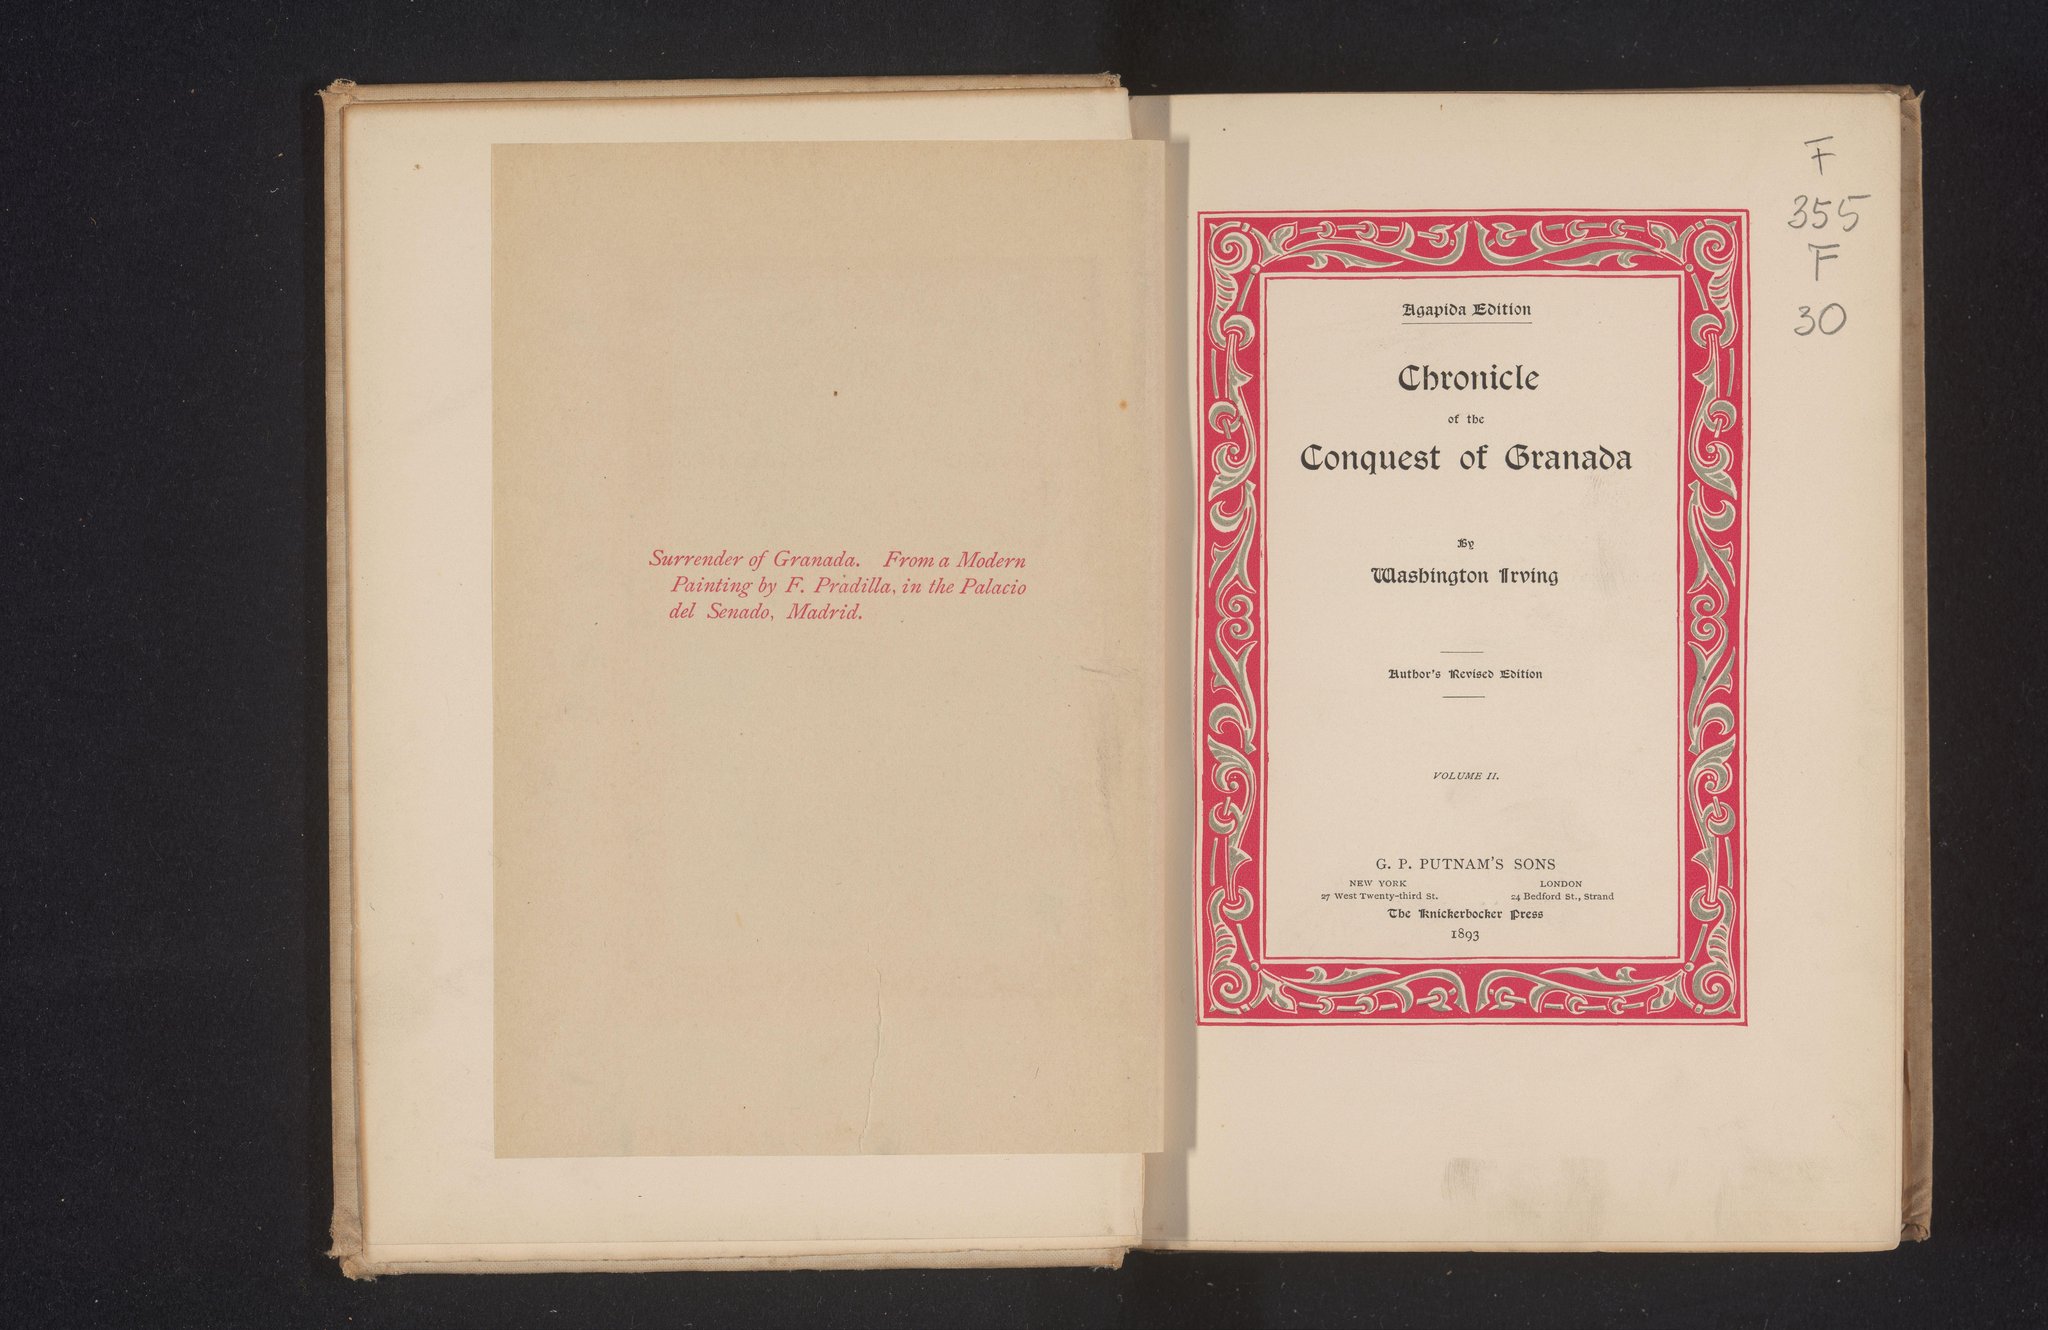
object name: book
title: Chronicle of the conquest of Granada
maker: washington irving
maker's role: schrijver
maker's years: 1783-1859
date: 1893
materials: linen, paper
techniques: photoaquatint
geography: new york city